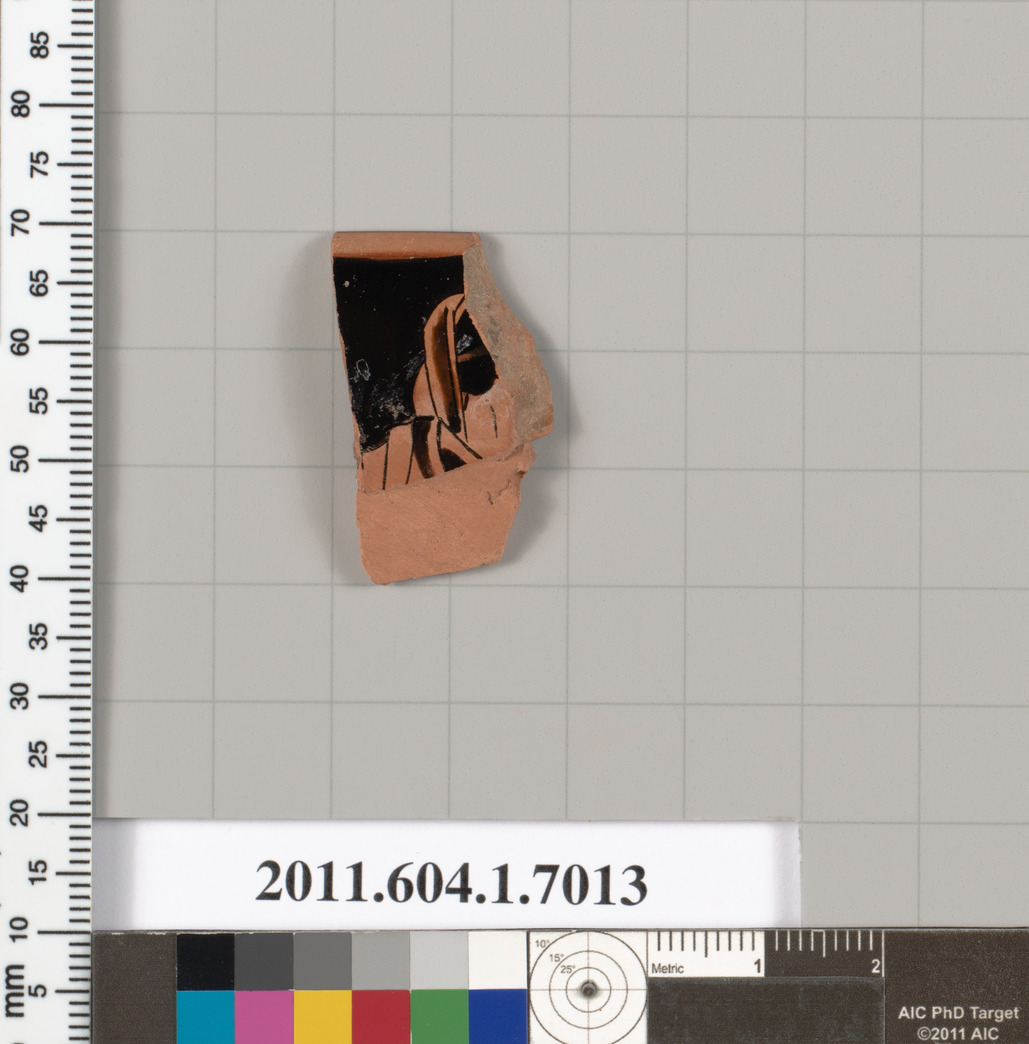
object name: kylix fragment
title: Terracotta rim fragment of a kylix (drinking cup)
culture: greek, attic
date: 500-480 BCE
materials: terracotta